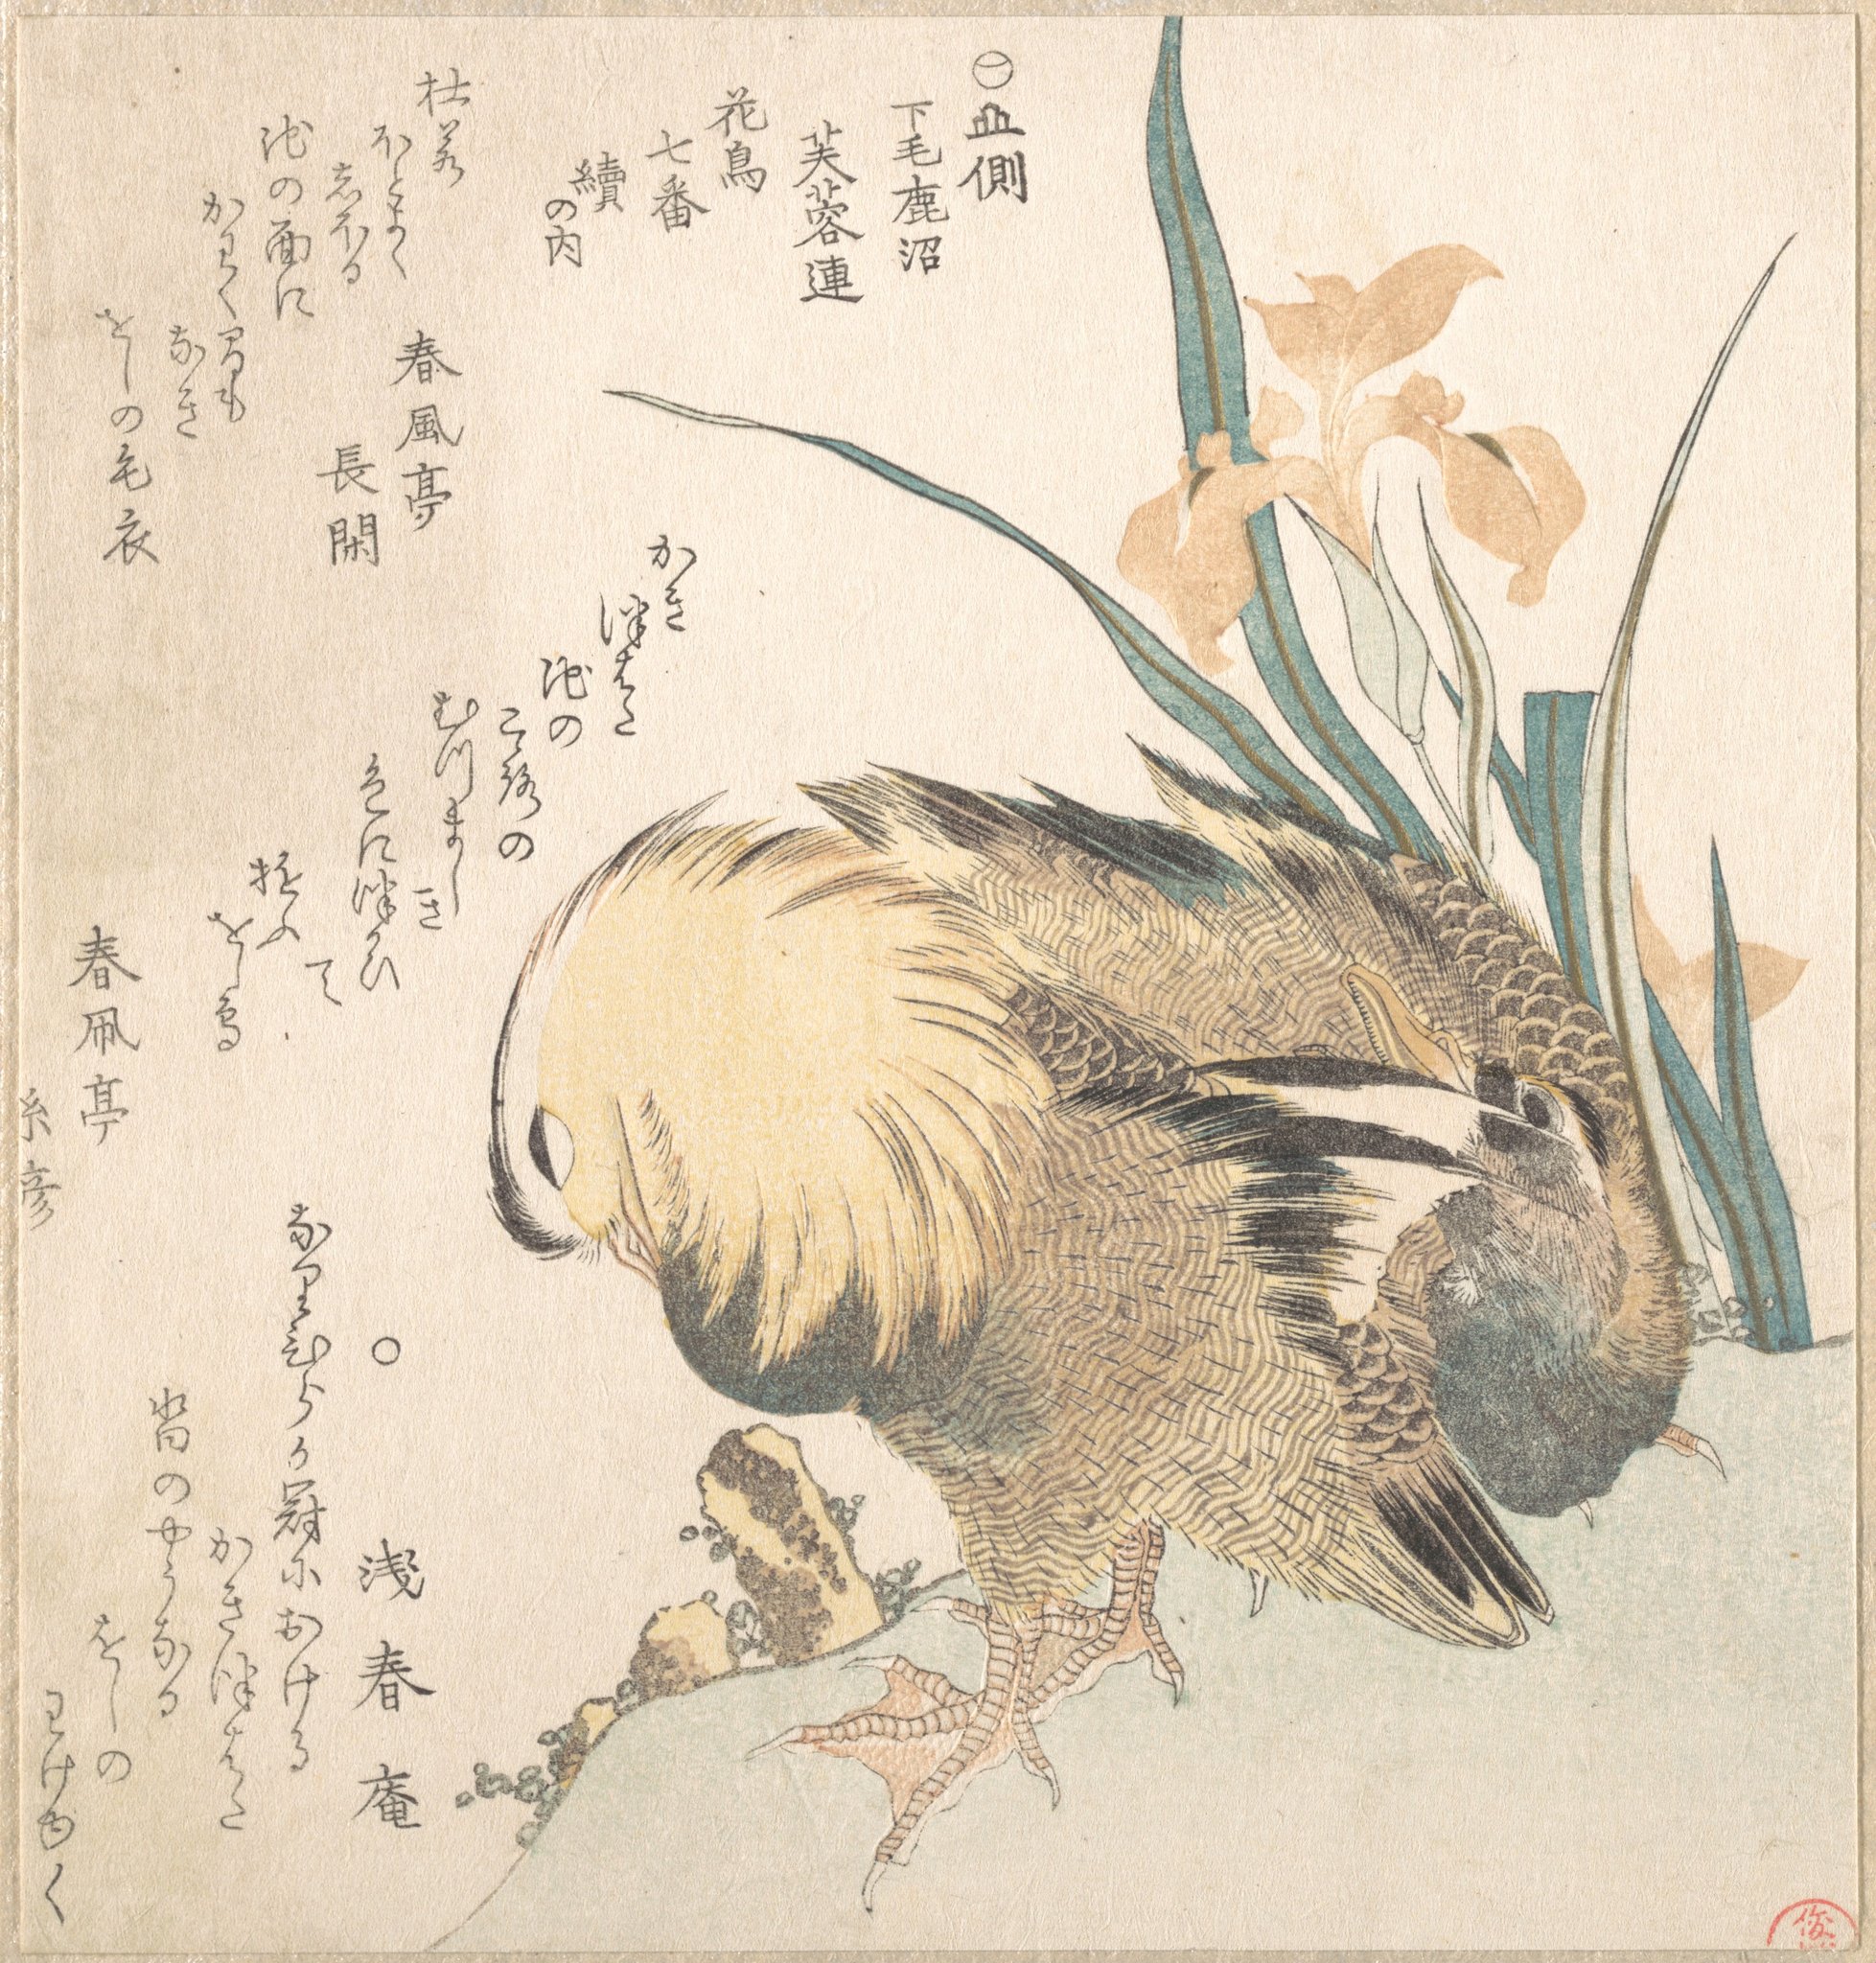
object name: woodblock print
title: Pair of Mandarin Ducks and Iris Flowers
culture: japanese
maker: kubo shunman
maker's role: artist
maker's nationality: japanese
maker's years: 1757-1820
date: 1780-1850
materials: ink, paper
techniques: surimono, woodblock print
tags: ducks,flowers